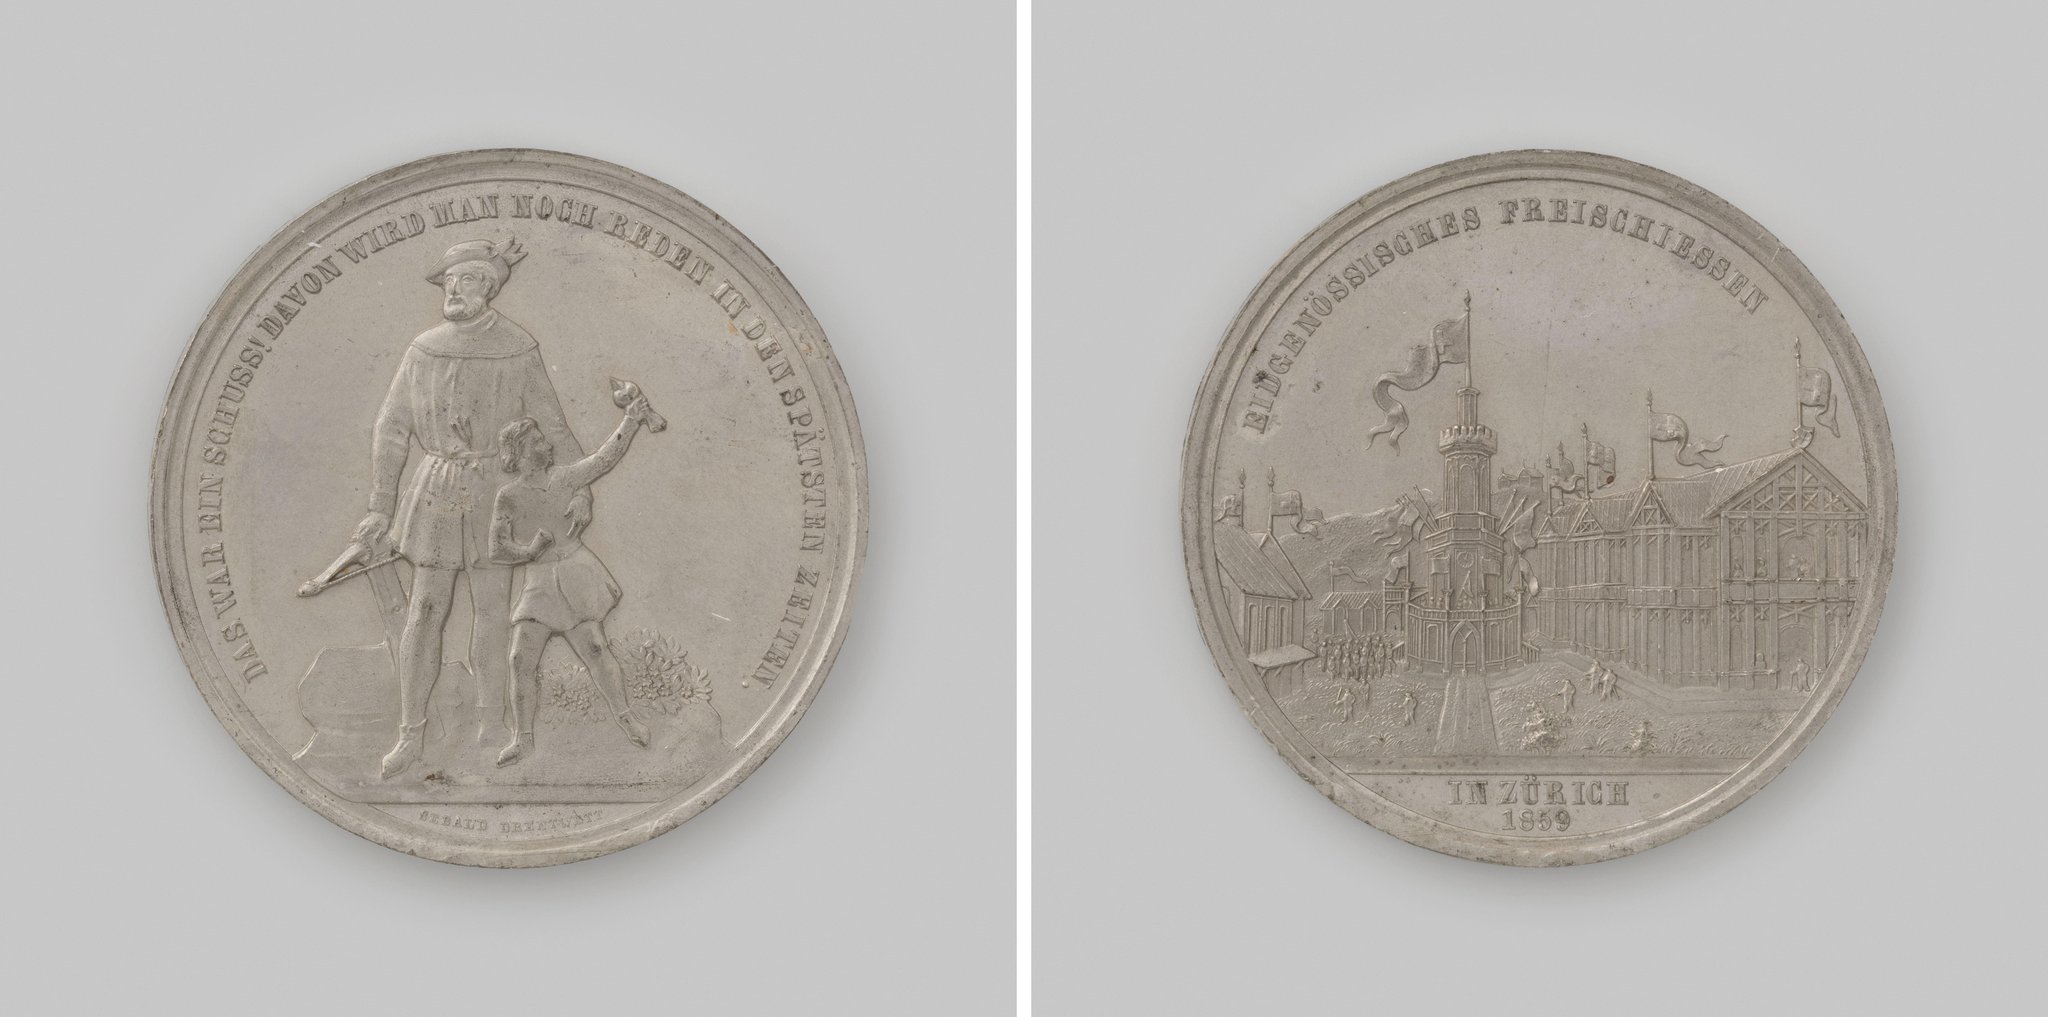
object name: marksman medal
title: Eidgenossisches Freischiessen te Zurich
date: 1859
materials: silver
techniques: striking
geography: augsburg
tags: zürich (stad)